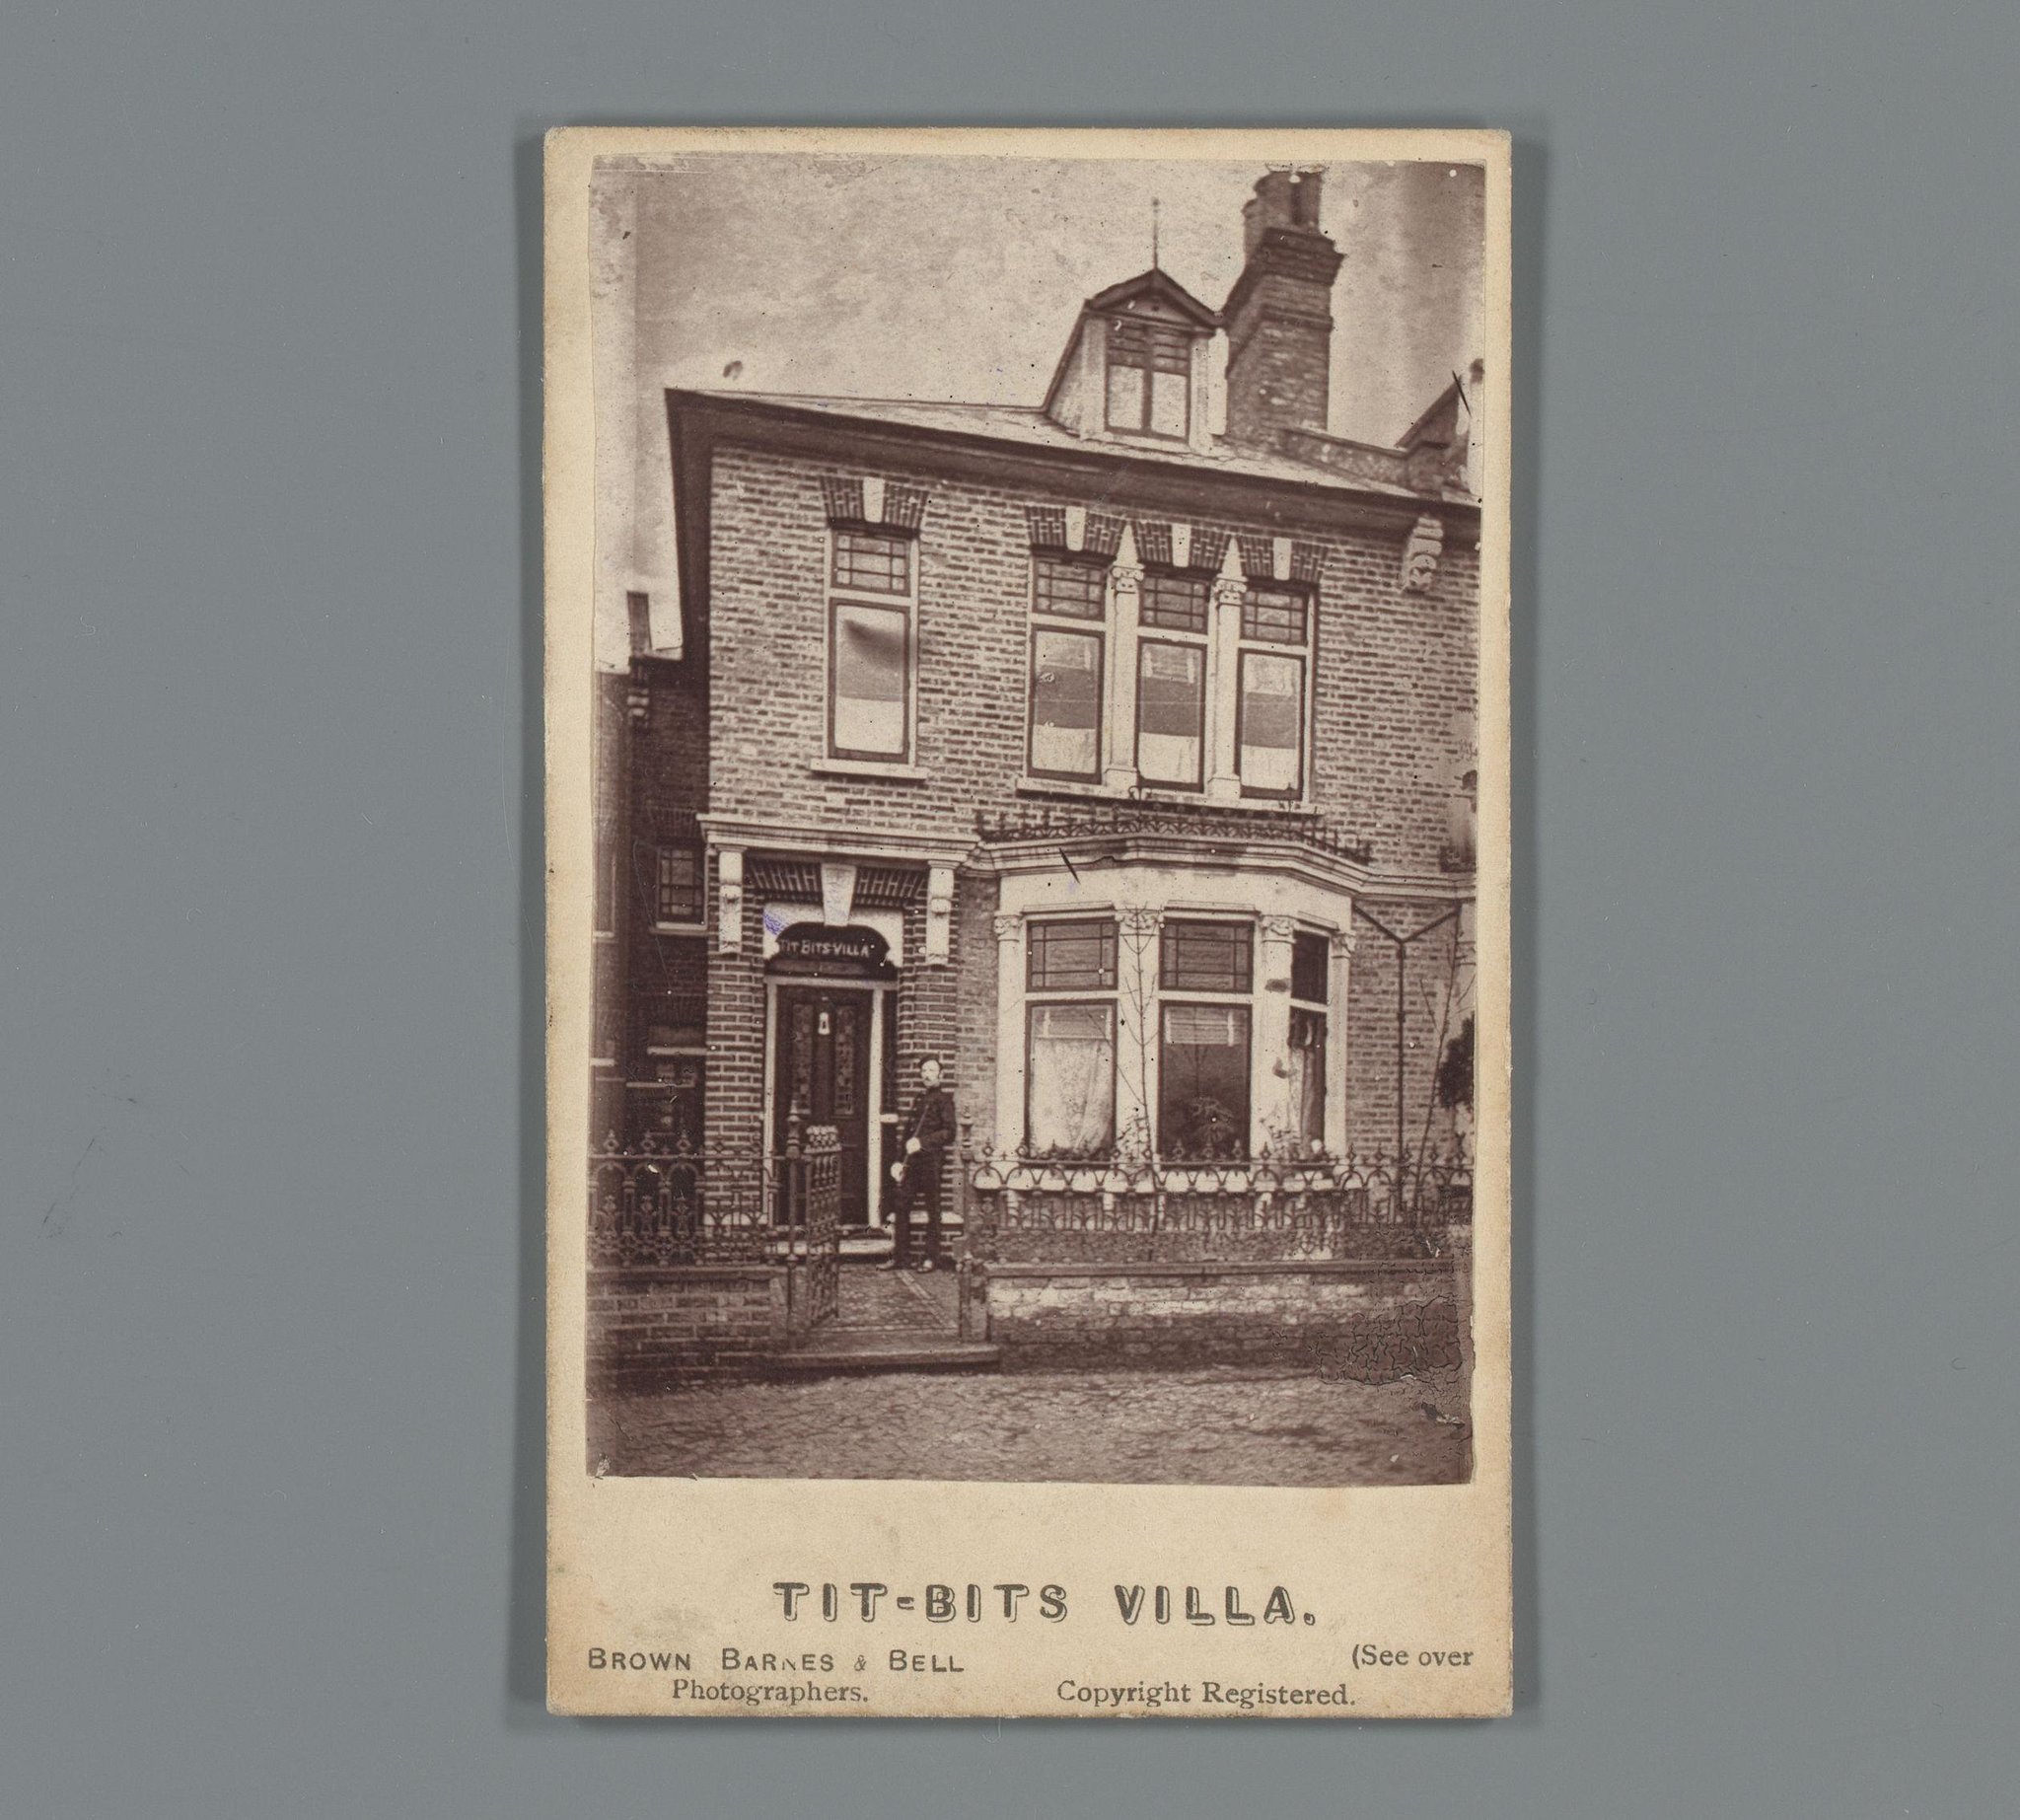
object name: photograph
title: Gezicht op de Londense woning gewonnen door William Robert Mellish voor zijn inzending bij tijdschrift Tit-Bits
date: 1883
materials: cardboard, photographic support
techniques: carbon print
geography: philadelphia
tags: advertising, historical persons, the usual house or row of houses, competition, art contest, london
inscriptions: inscription: ‘THIS VILLA WAS WON/ BY/ Private Wm. Robt. Mellish,/ of the/ 8th HUSSARS,/ in the/ TIT-BITS CHRISTMAS/ COMPETITION, 1883./ The Winner is seen standing by/ the Porch./ PERMANENT PHOTOGRAPH BY/ BROWN, BARNES & BELL,/ THE PHOTOGRAPHERS.’, inscription: ‘SPECIMEN COPY’